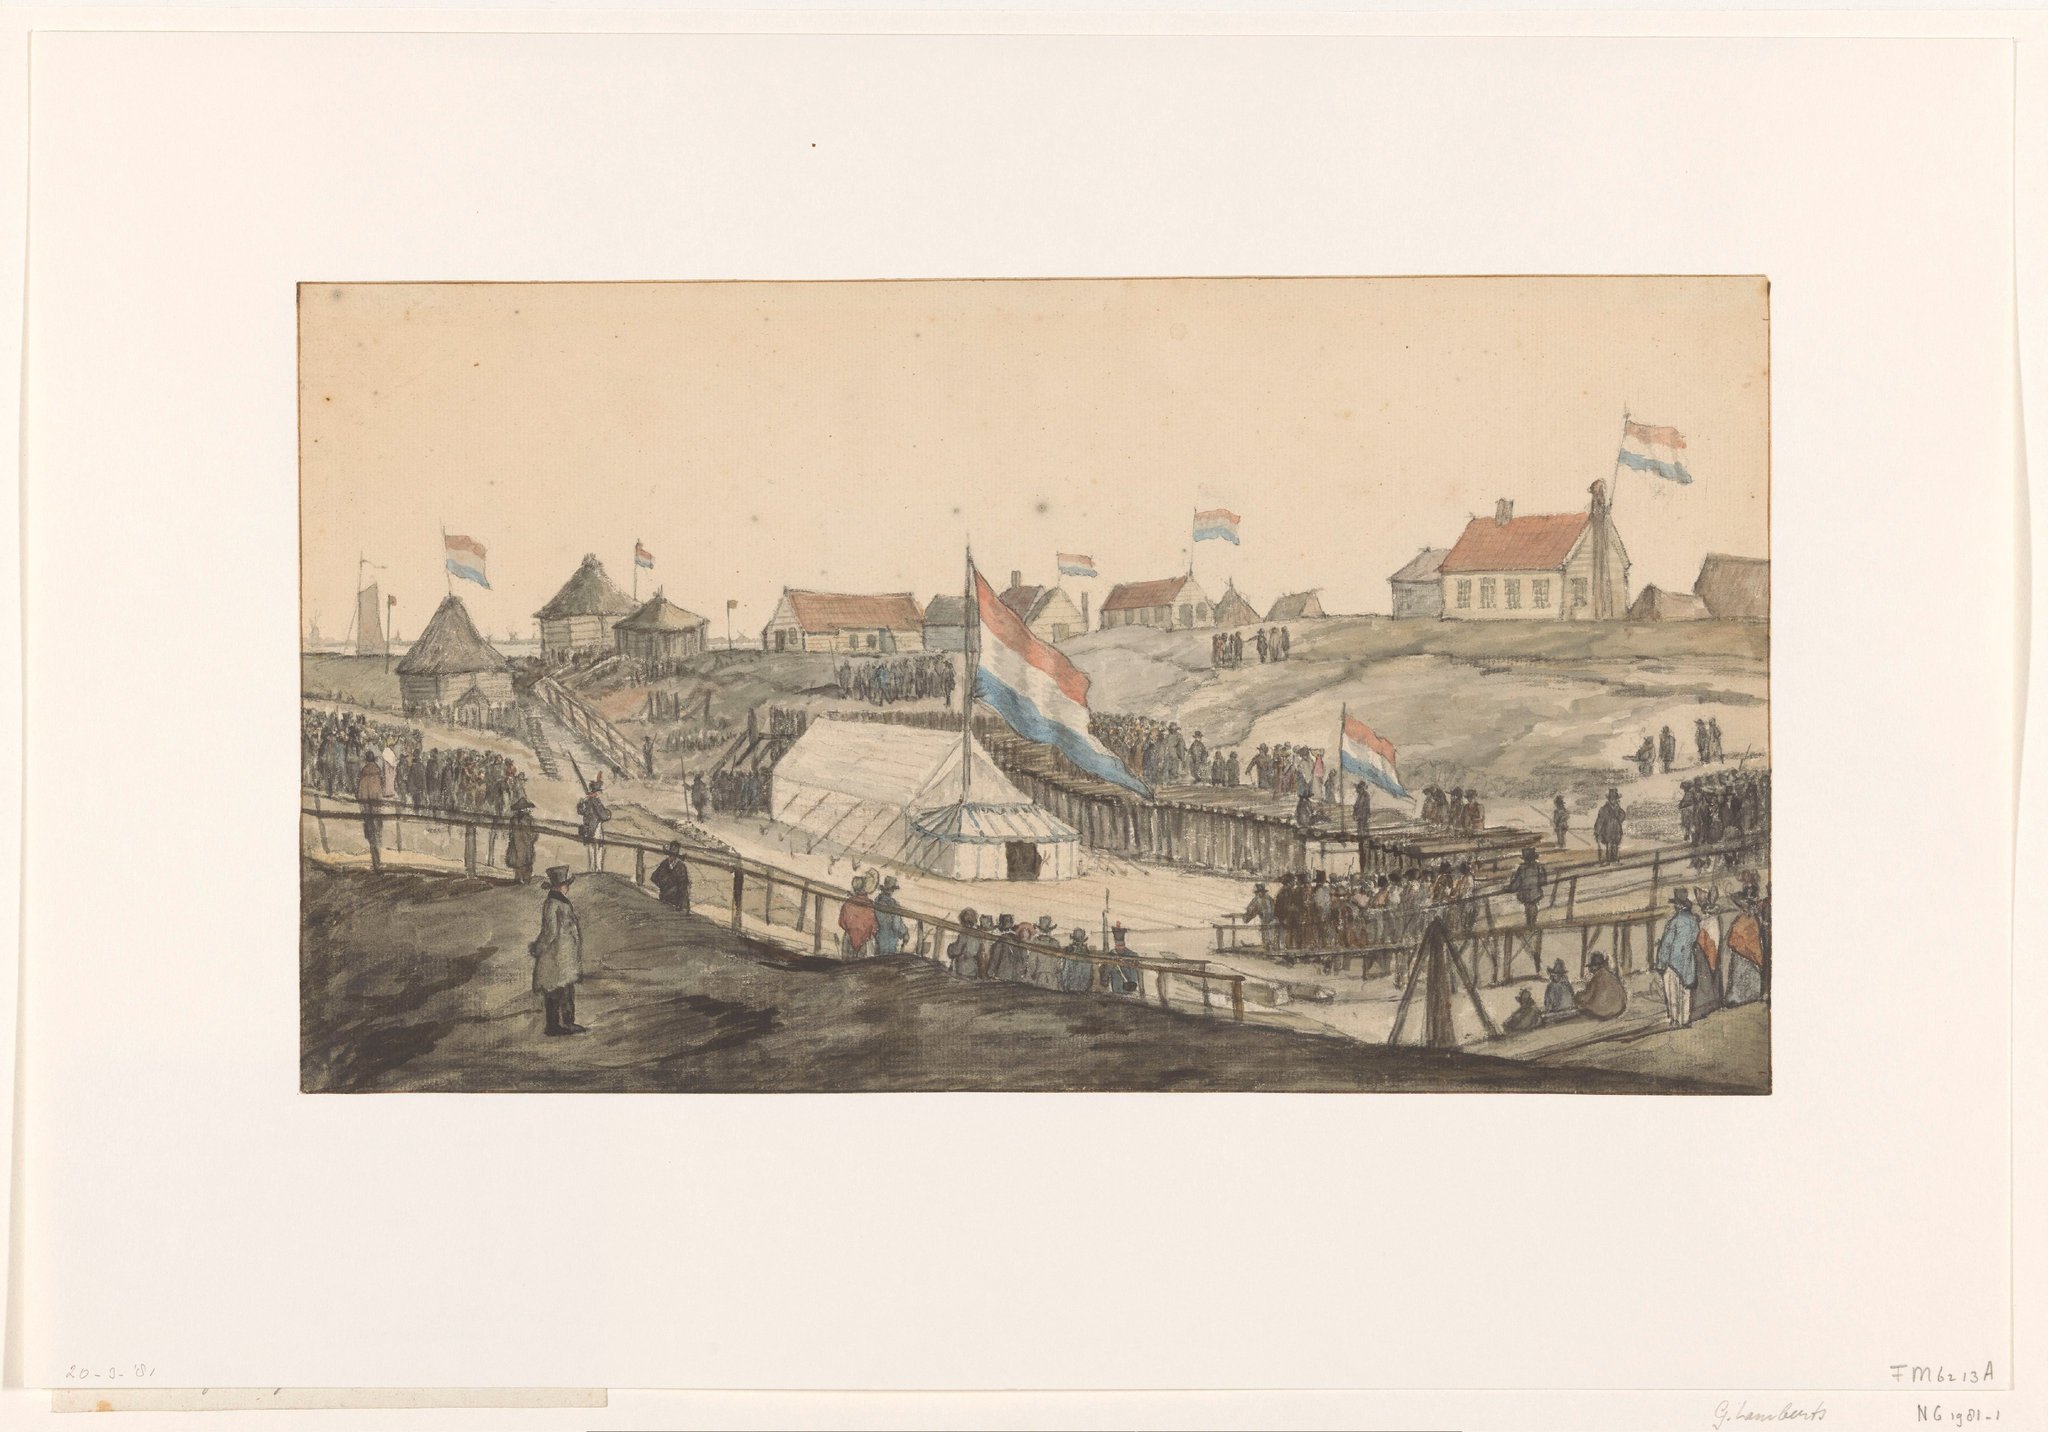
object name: watercolor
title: Opening van de Willemsluis in het Noordhollandsch Kanaal op 13 december 1824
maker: gerrit lamberts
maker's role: bookseller, draughtsman, print maker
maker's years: 1776-1850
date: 1820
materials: chalk, paper, pencil, watercolor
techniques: brush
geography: amsterdam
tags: jan blanken jansz.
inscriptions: signature: ‘G. Lamberts fect. ad vivum’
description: De voorstelling van deze tekening is eerder geïdentificeerd als de opening van de Willemssluizen in 1824. Omdat er duidelijk een bouwput is te zien en er nog geen sprake is van een voltooide sluis, is het warschijnlijker dat een eerder moment is voorgesteld, namelijk de eerstesteenlegging voor de bouw van de sluis. Deze nieuwe interpretatie voorgesteld door Margreet Visser en Frits Prior, sept. 2013. Zie de vergelijkbare tekening door Lamberts in de collectie Atlas Amsterdam van het KOG. Het bijgevoegde pasje lijkt niets te maken te hebben met de voorgestelde gebeurtenis. Niet in Frederik Muller; door het RPK toegevoegd nummer.